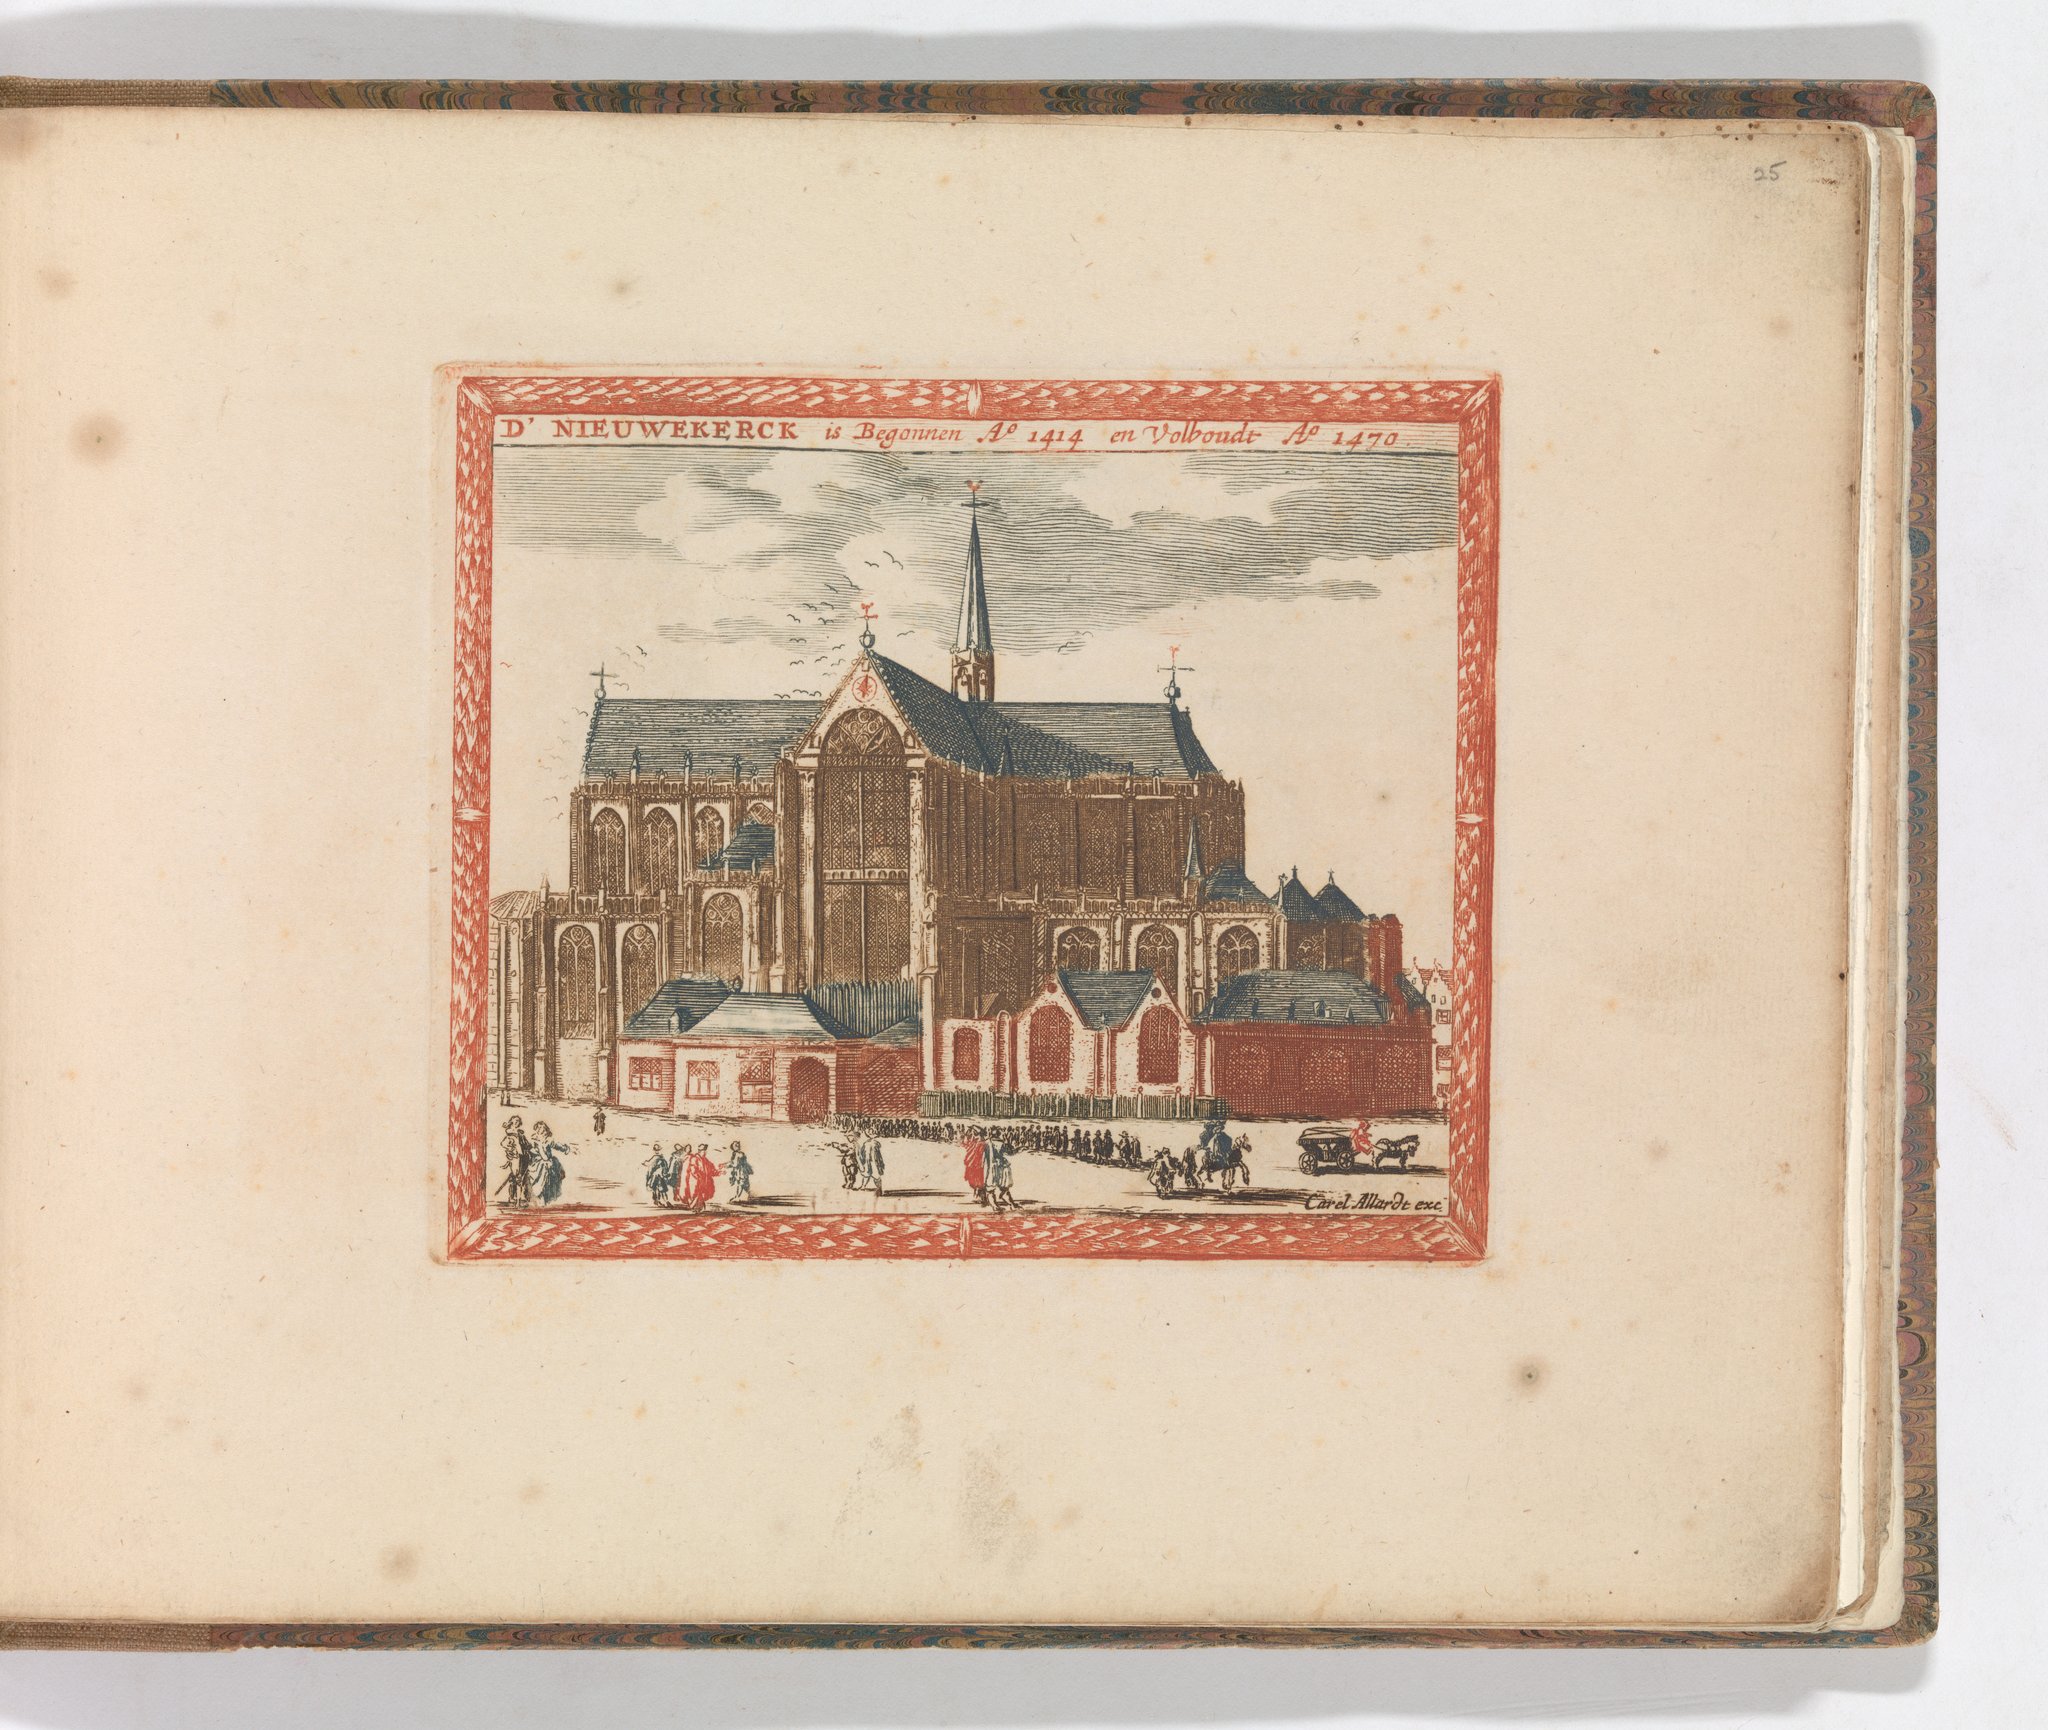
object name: book print ornament architecture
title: 'D' Nieuwe Kerck', in: Tooneel Der Voornaamste Nederlands Huizen, En Lust Hoven, Naar T Leven Afgebeeld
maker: carel allard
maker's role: publisher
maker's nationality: dutch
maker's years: 1648-1709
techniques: engraving, lithography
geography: amsterdam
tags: human figures,churches